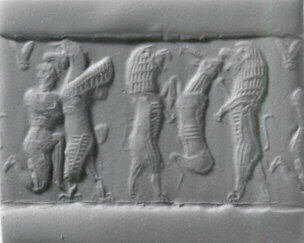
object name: cylinder seal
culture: babylonian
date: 1900-1601 BCE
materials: stone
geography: mesopotamia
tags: men,lions